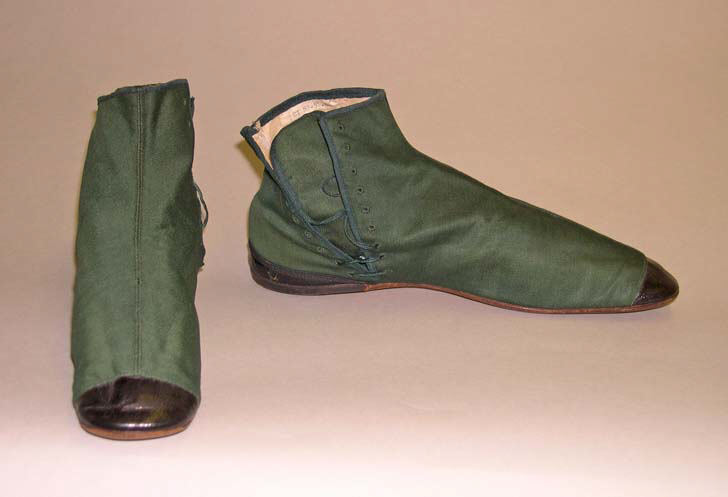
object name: shoe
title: Shoes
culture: american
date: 1840-1849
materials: leather, silk, wool